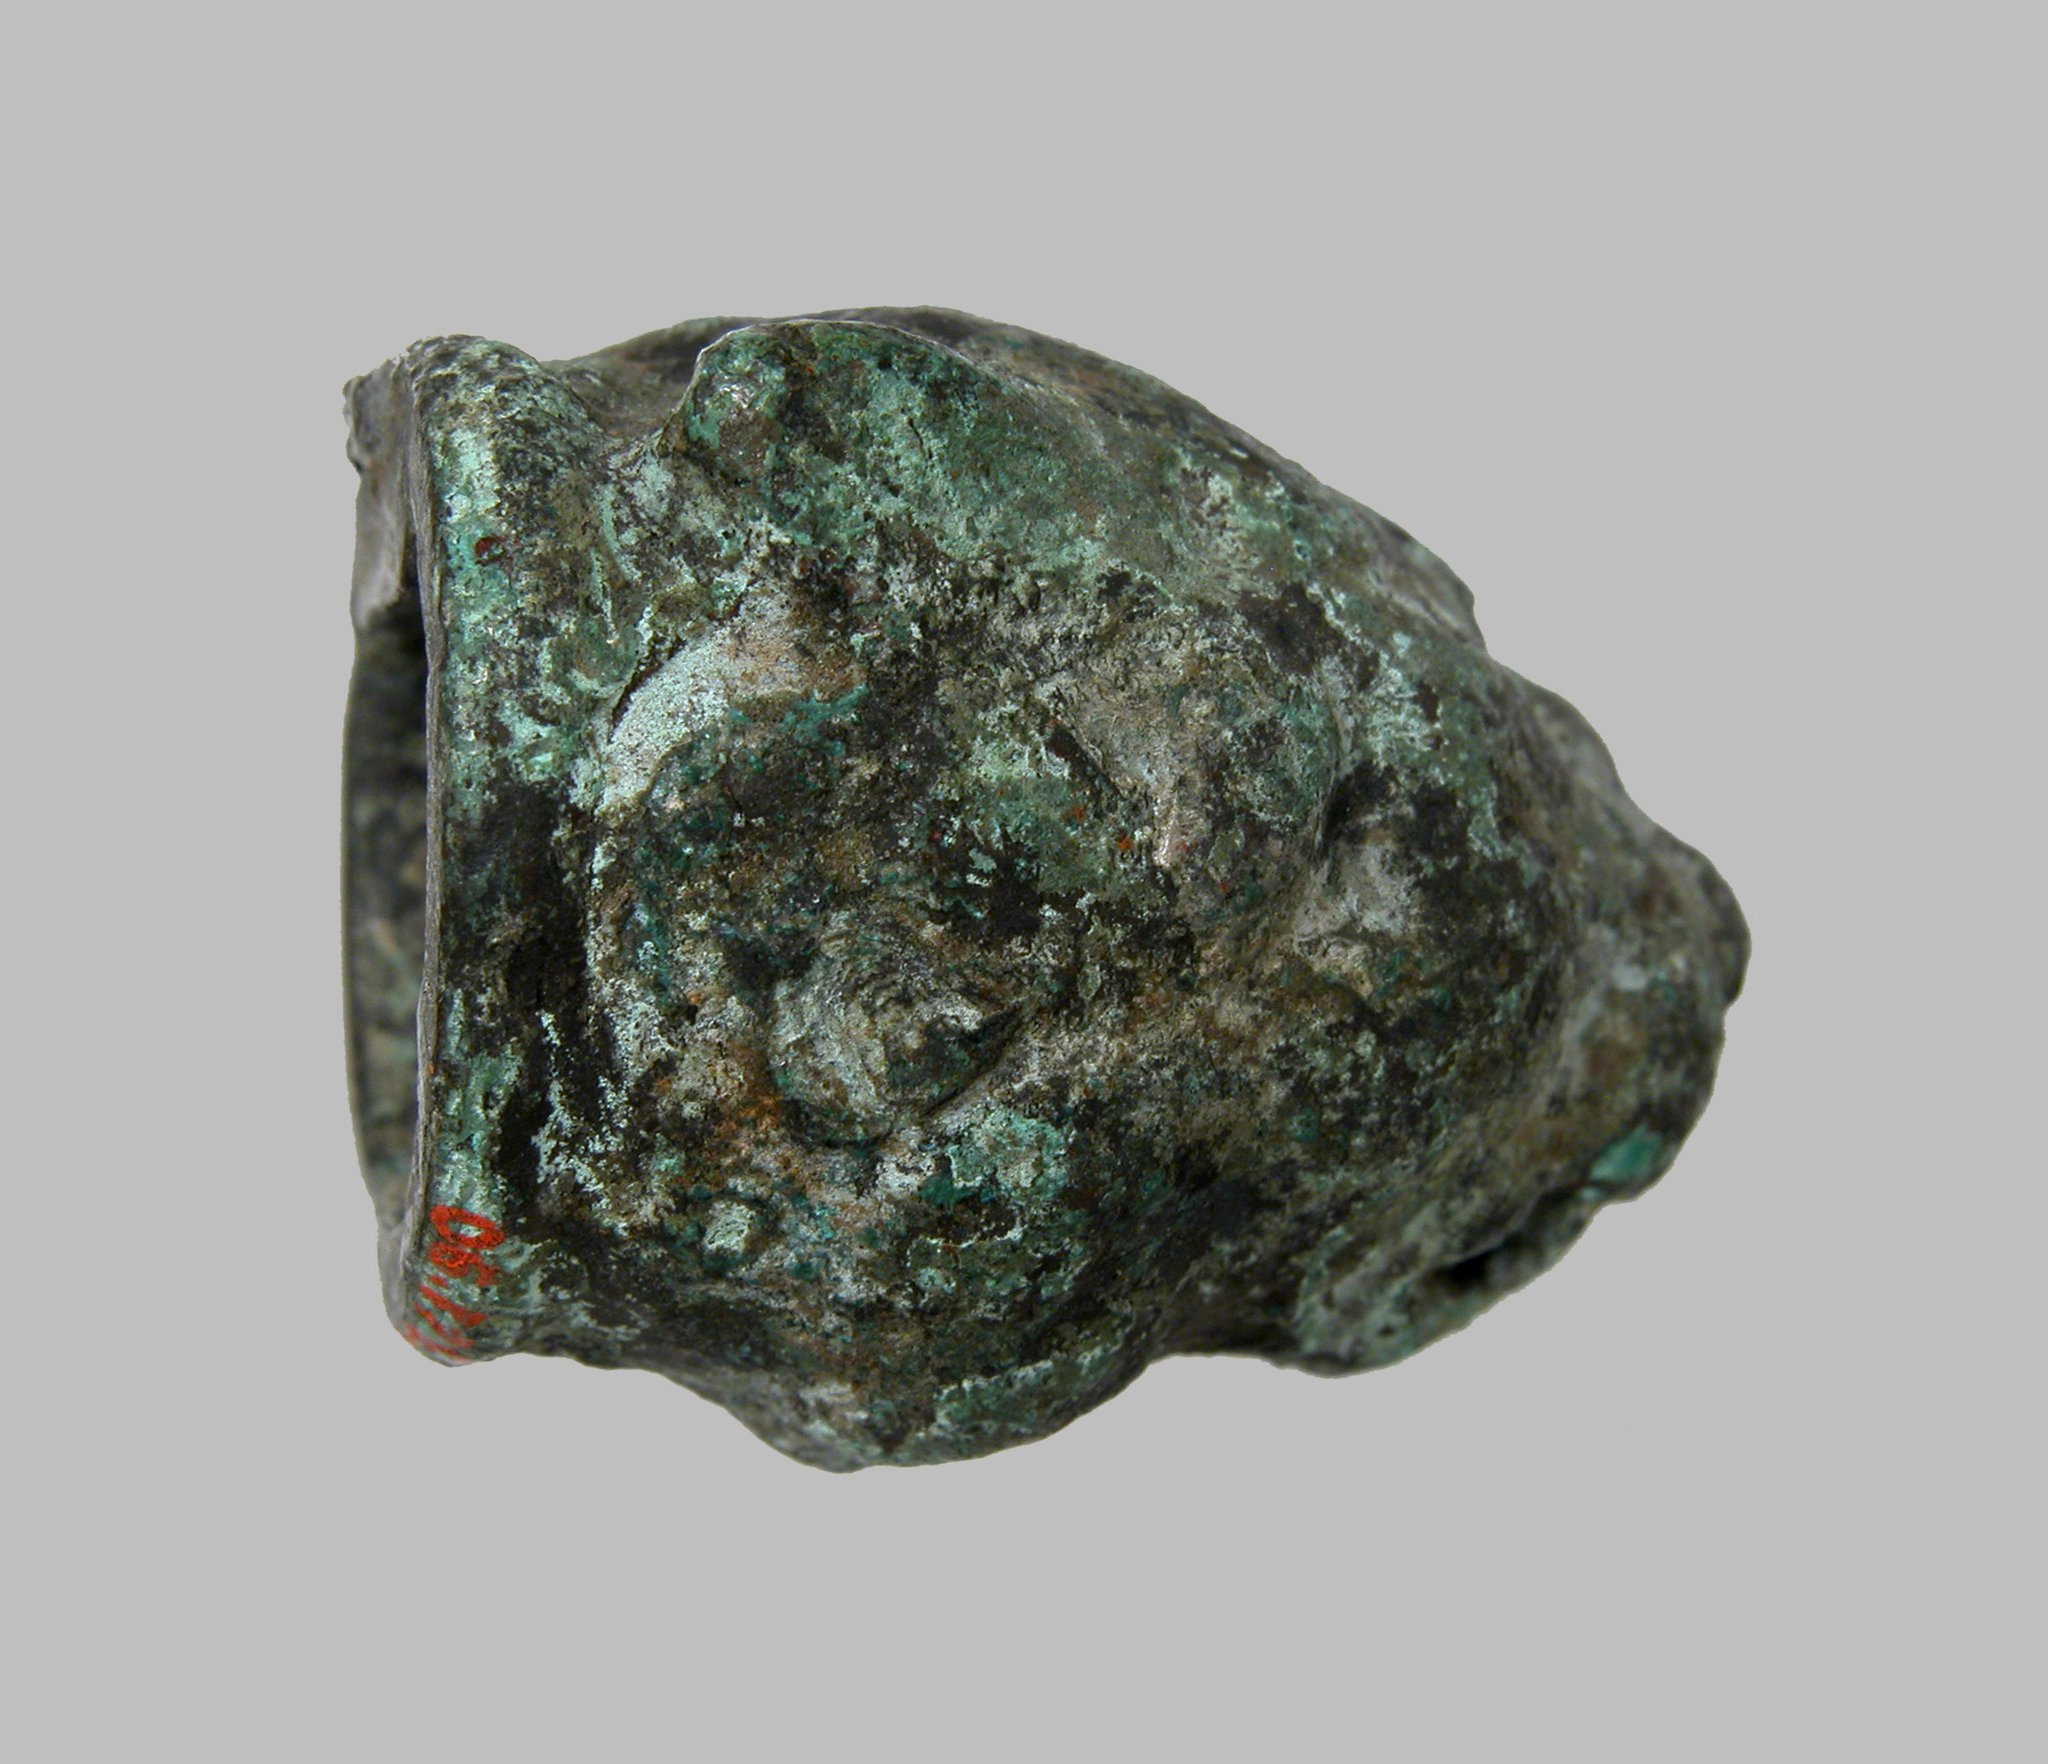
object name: key handle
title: Fragment of Key Handle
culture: roman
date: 1-700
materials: copper alloy